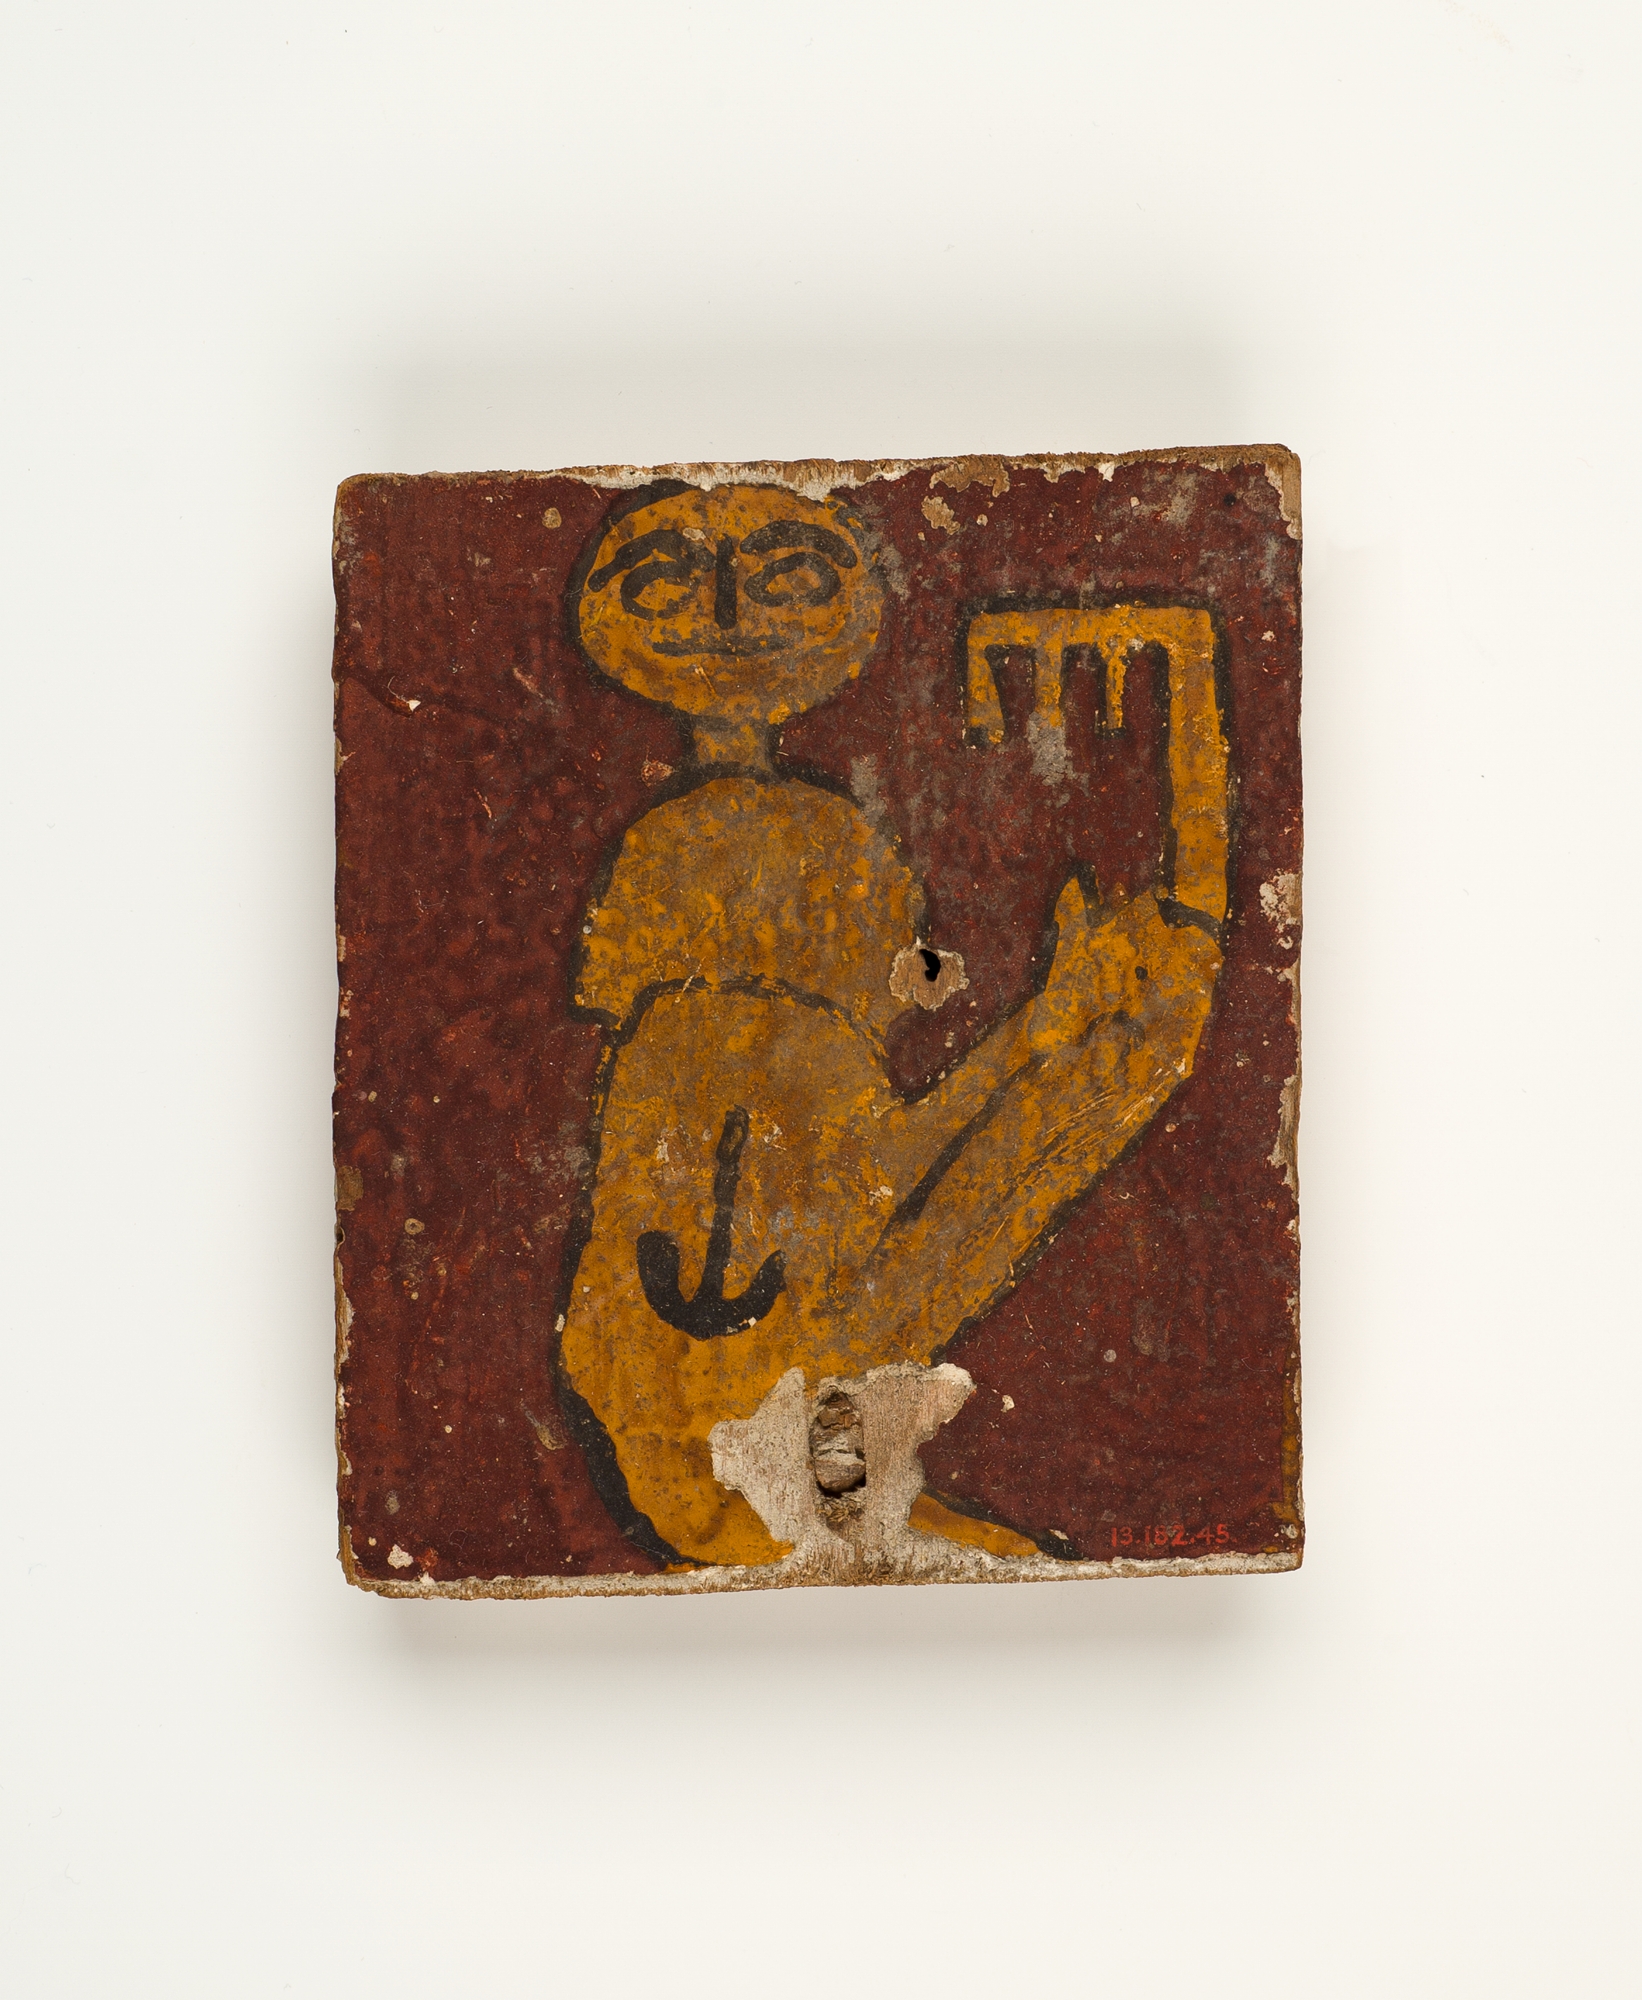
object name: panel, crouching figure, key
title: Panel with crouching figure holding a key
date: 100-300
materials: paint, plaster, wood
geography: egypt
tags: human figures,keys